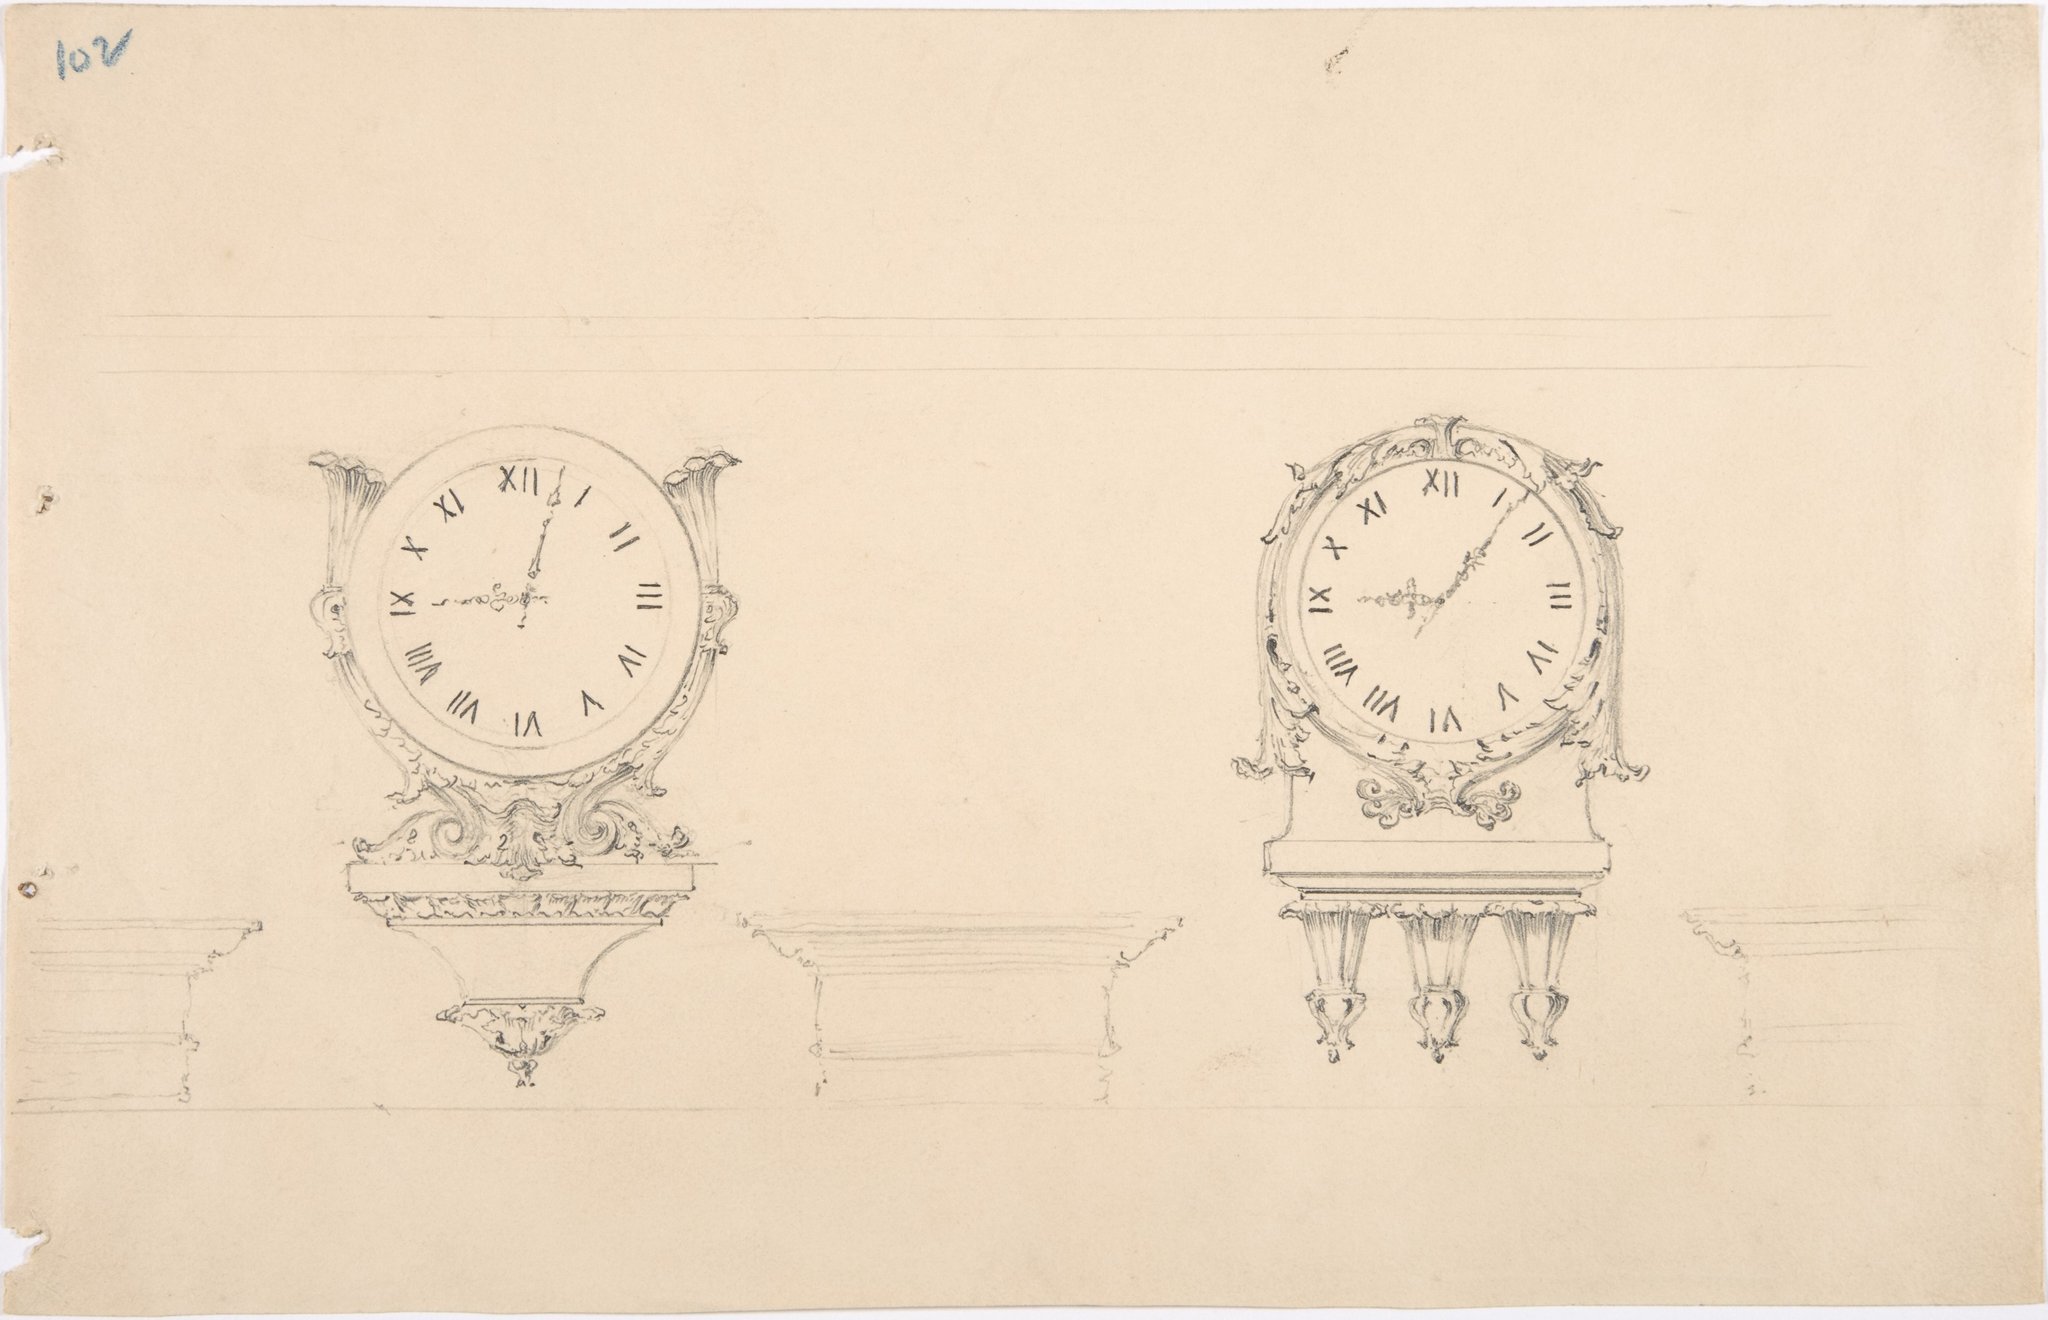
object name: drawing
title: Design for Two Clocks and Three Brackets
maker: anonymous, british, 19th century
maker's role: artist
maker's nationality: british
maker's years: 1800-1900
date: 1801-1833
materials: graphite, ink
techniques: pen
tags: clocks